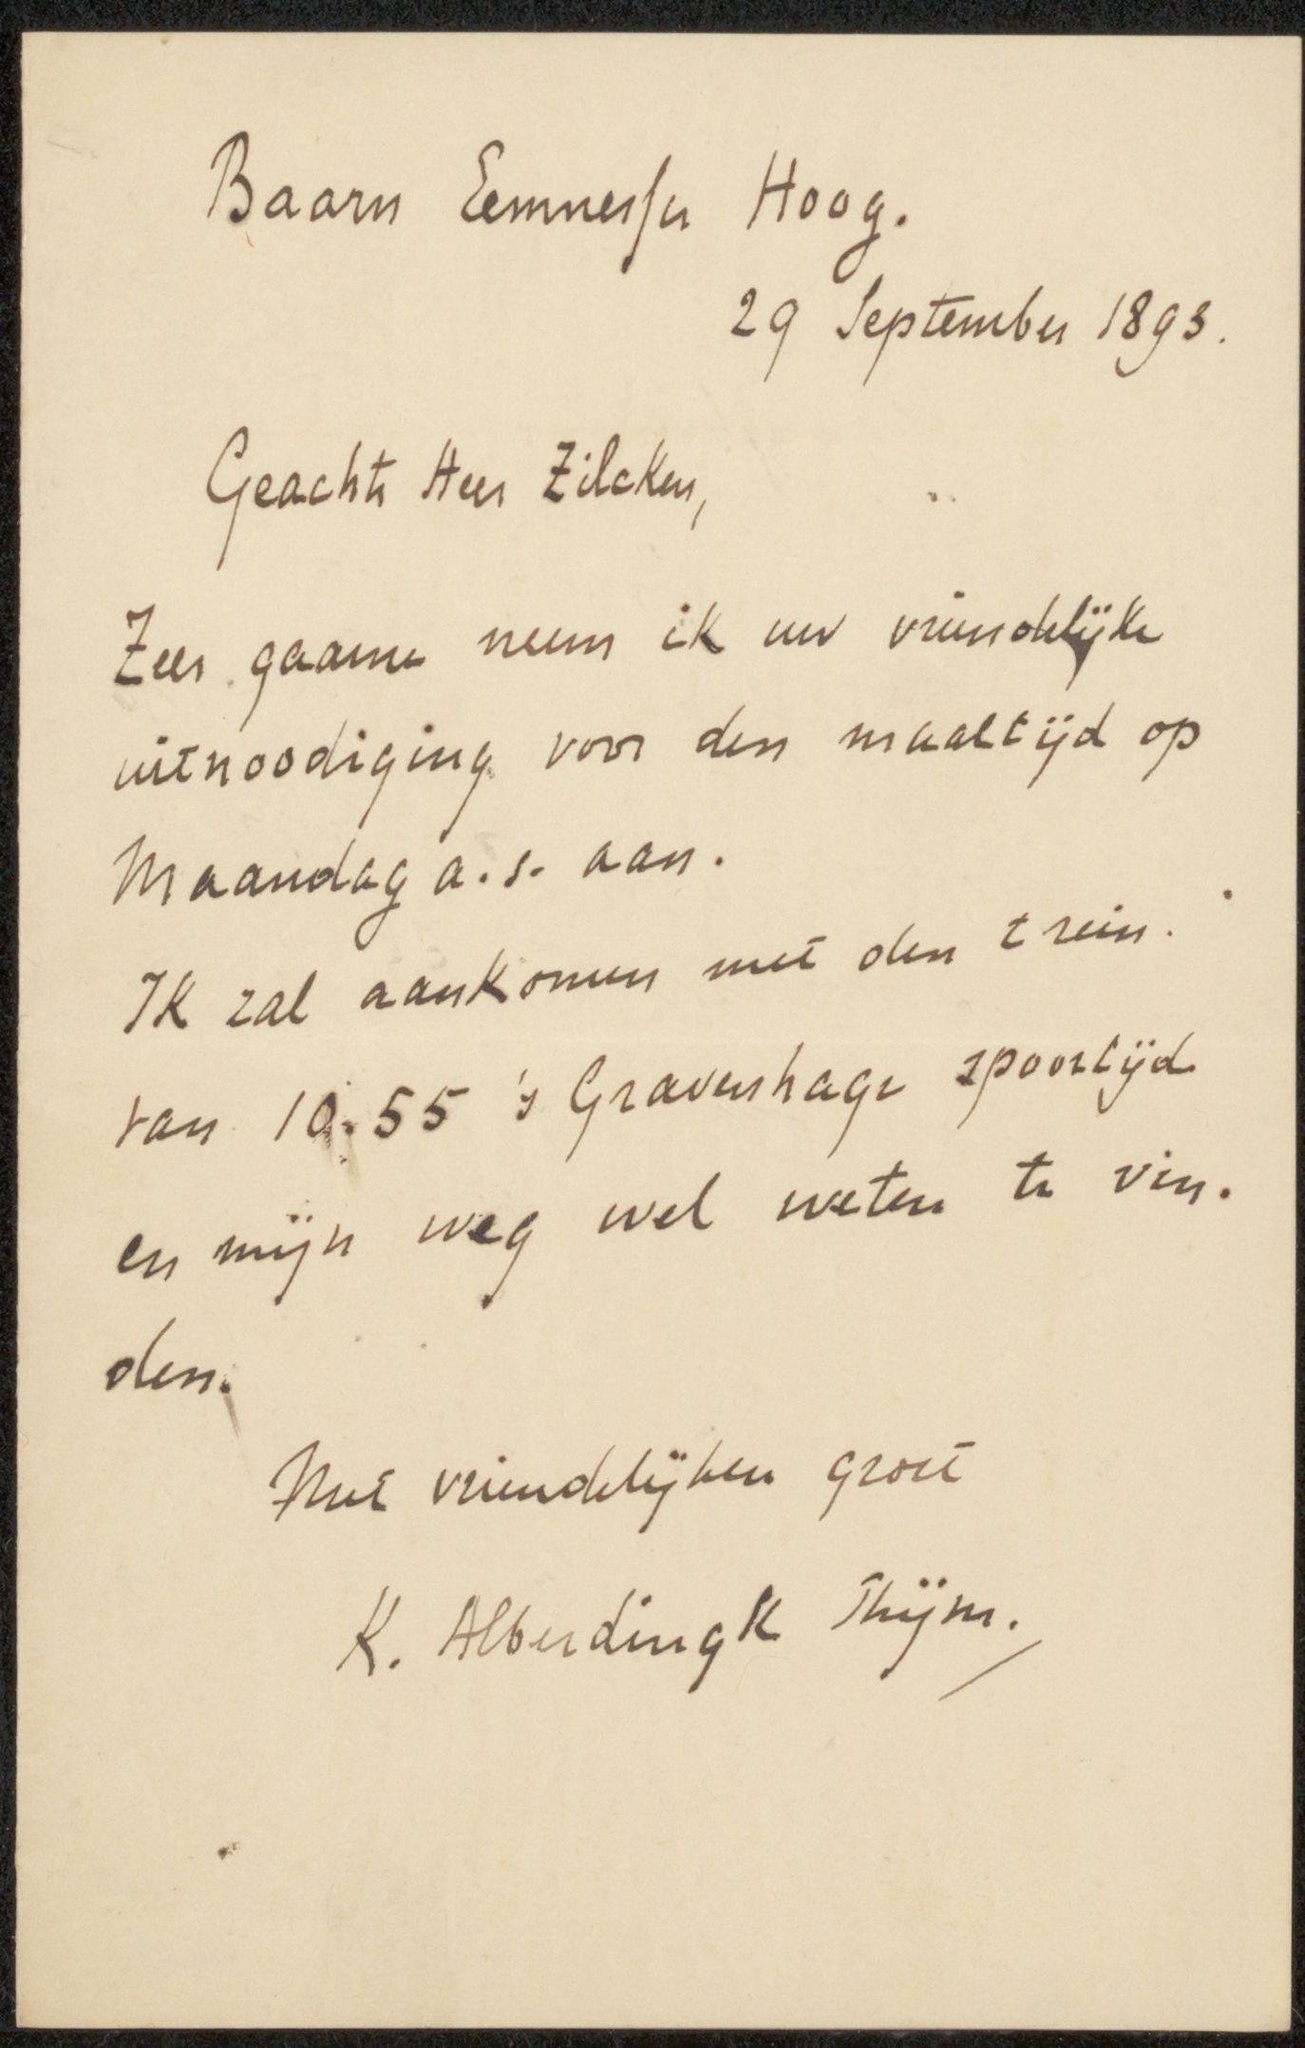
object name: letter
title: Brief aan Philip Zilcken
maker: karel johan lodewijk alberdingk thijm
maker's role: criticus, prozaschrijver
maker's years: 1864-1952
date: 1893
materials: ink, paper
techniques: pen, writing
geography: baarn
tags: the hague, painter, draughtsman, philip zilcken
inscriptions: collector's mark: ‘RPK’